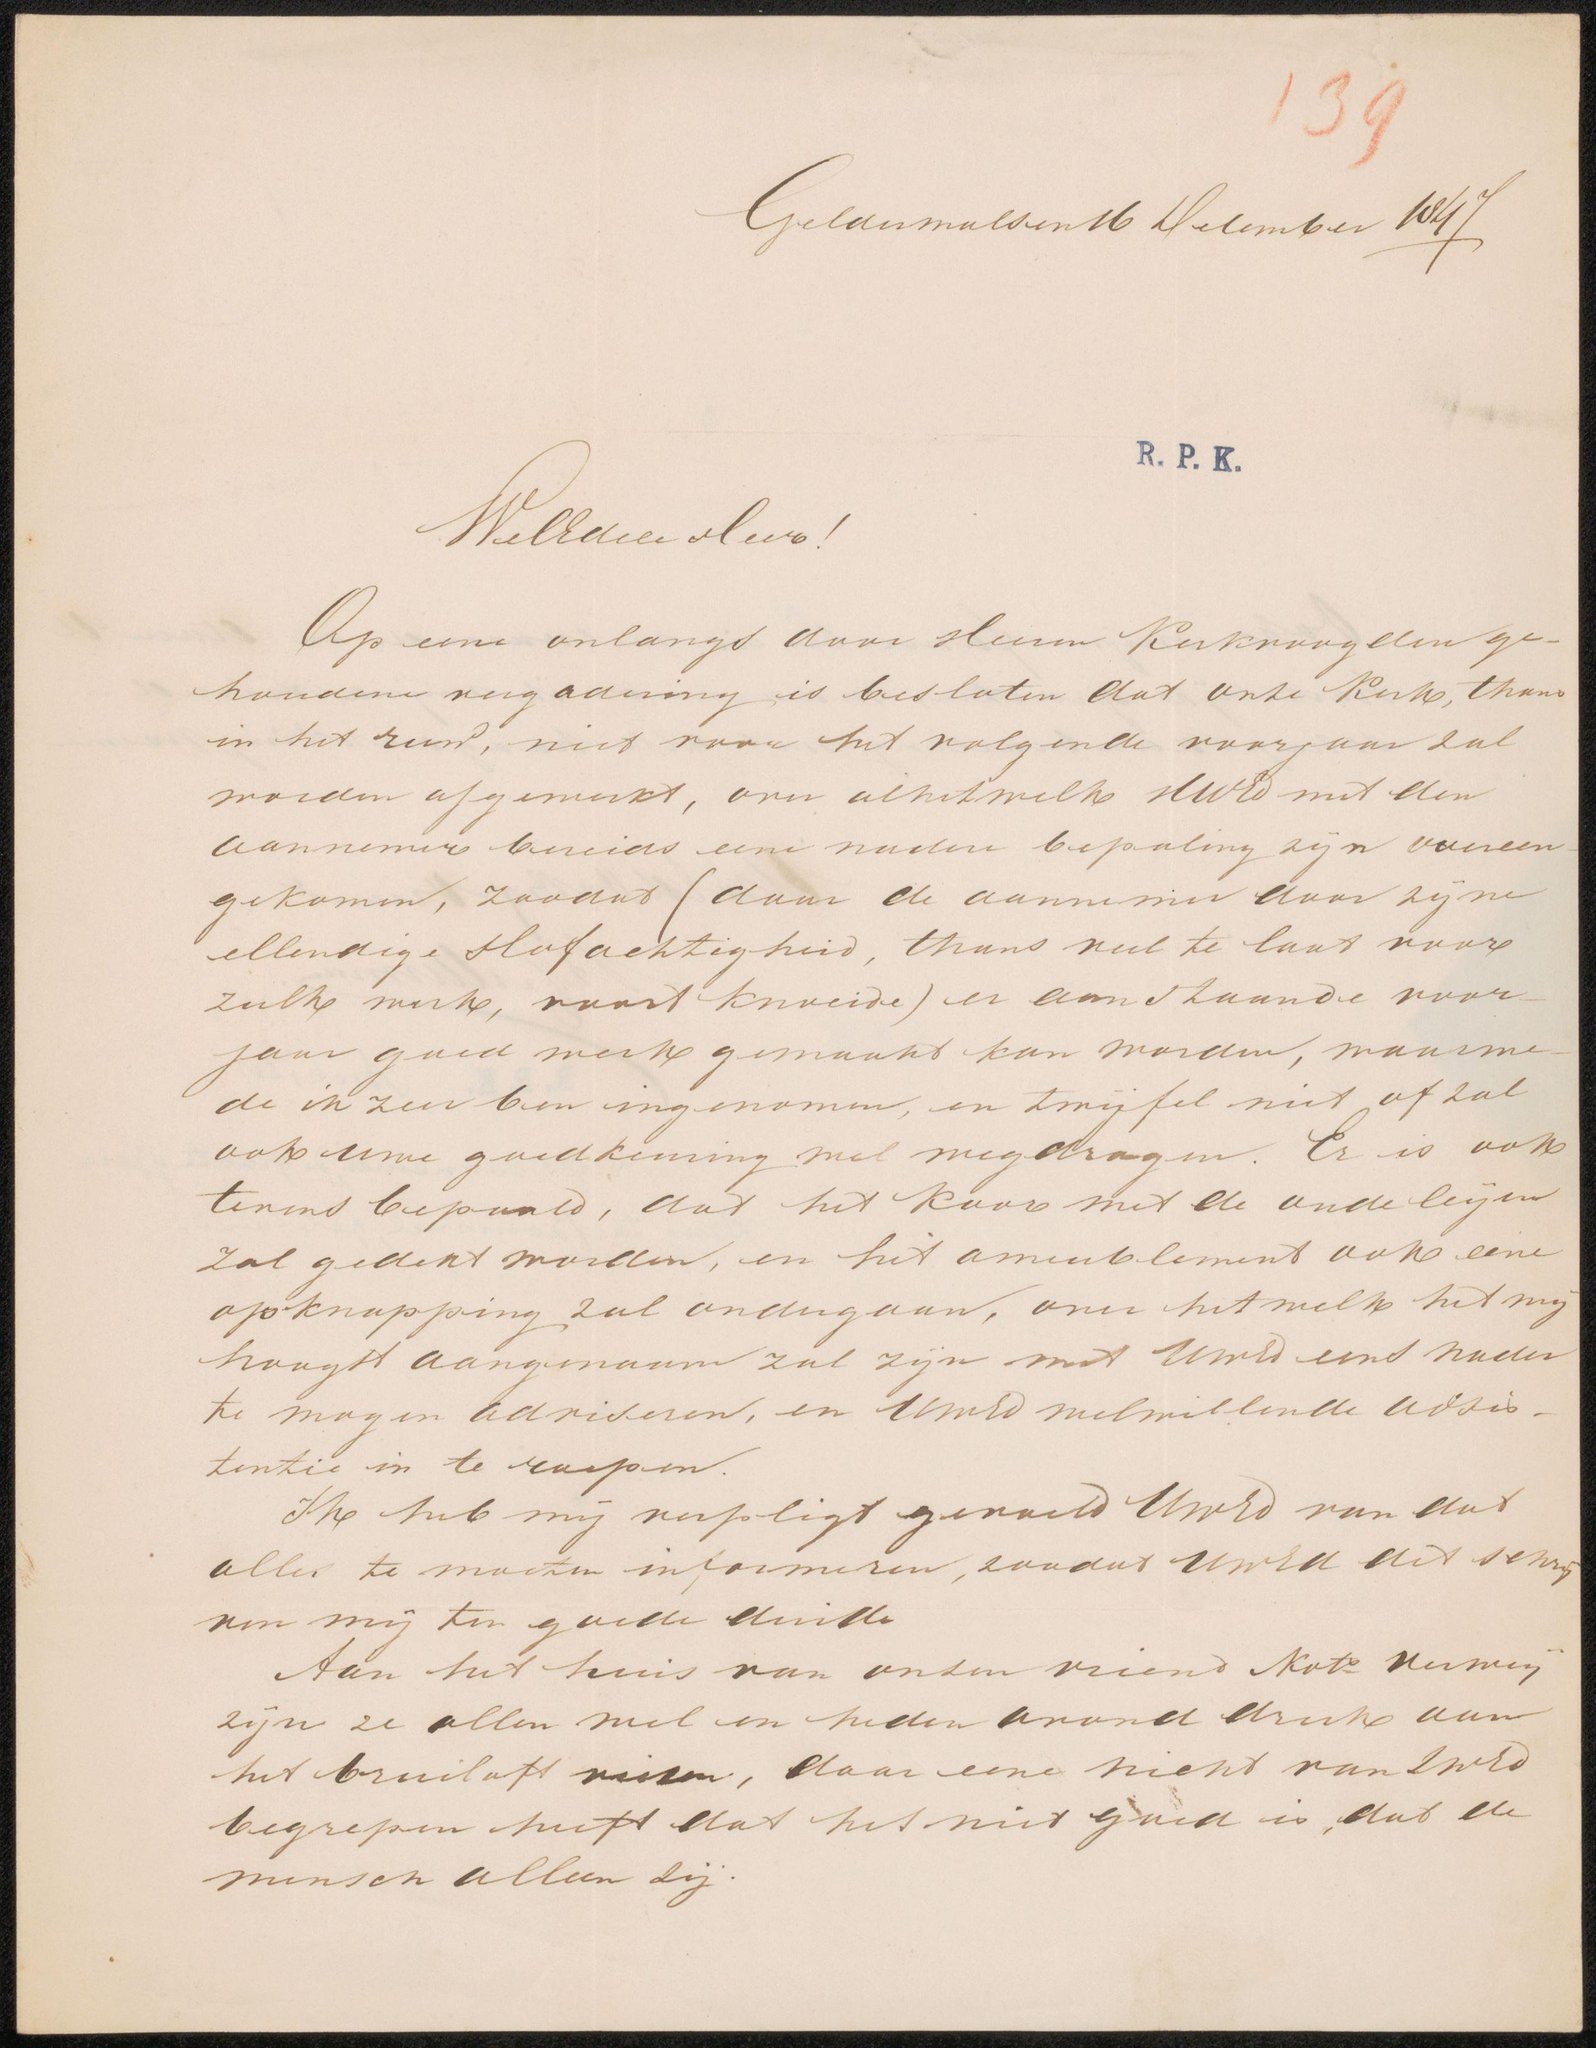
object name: letter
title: Brief aan Christiaan Kramm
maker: reijer catharinus murman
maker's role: draughtsman, painter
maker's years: 1908-1981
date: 1847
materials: ink, paper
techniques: pen, writing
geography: geldermalsen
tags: utrecht, print maker, draughtsman, christiaan kramm, architecture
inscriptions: collector's mark: Lugt 2233